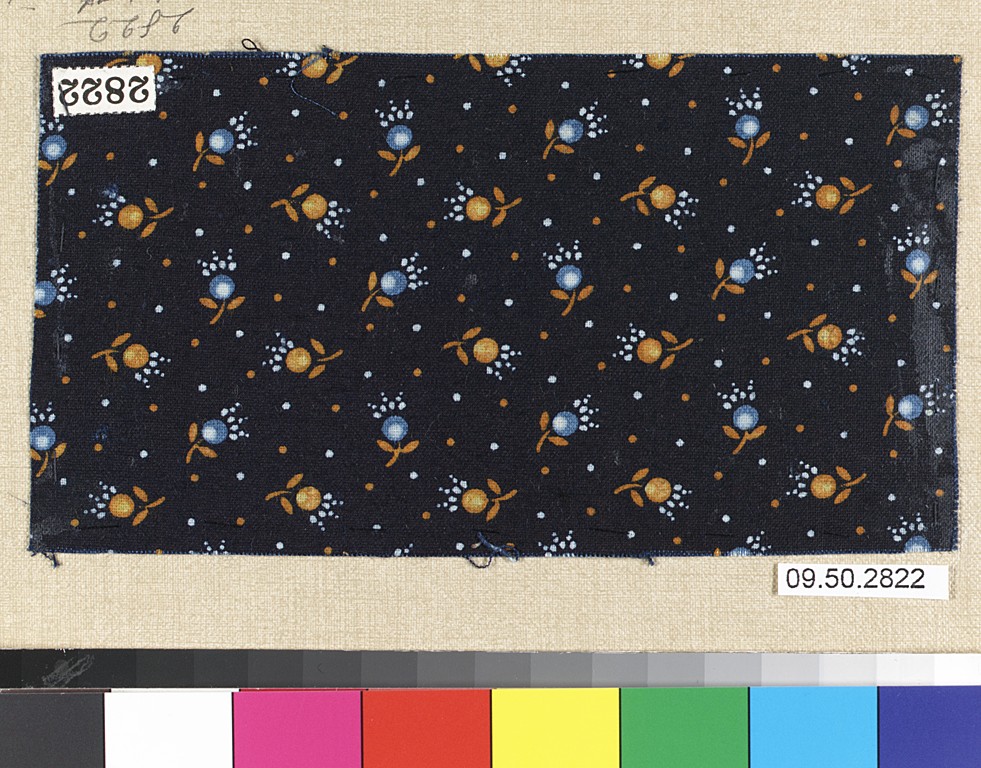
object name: piece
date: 1801-1900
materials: cotton